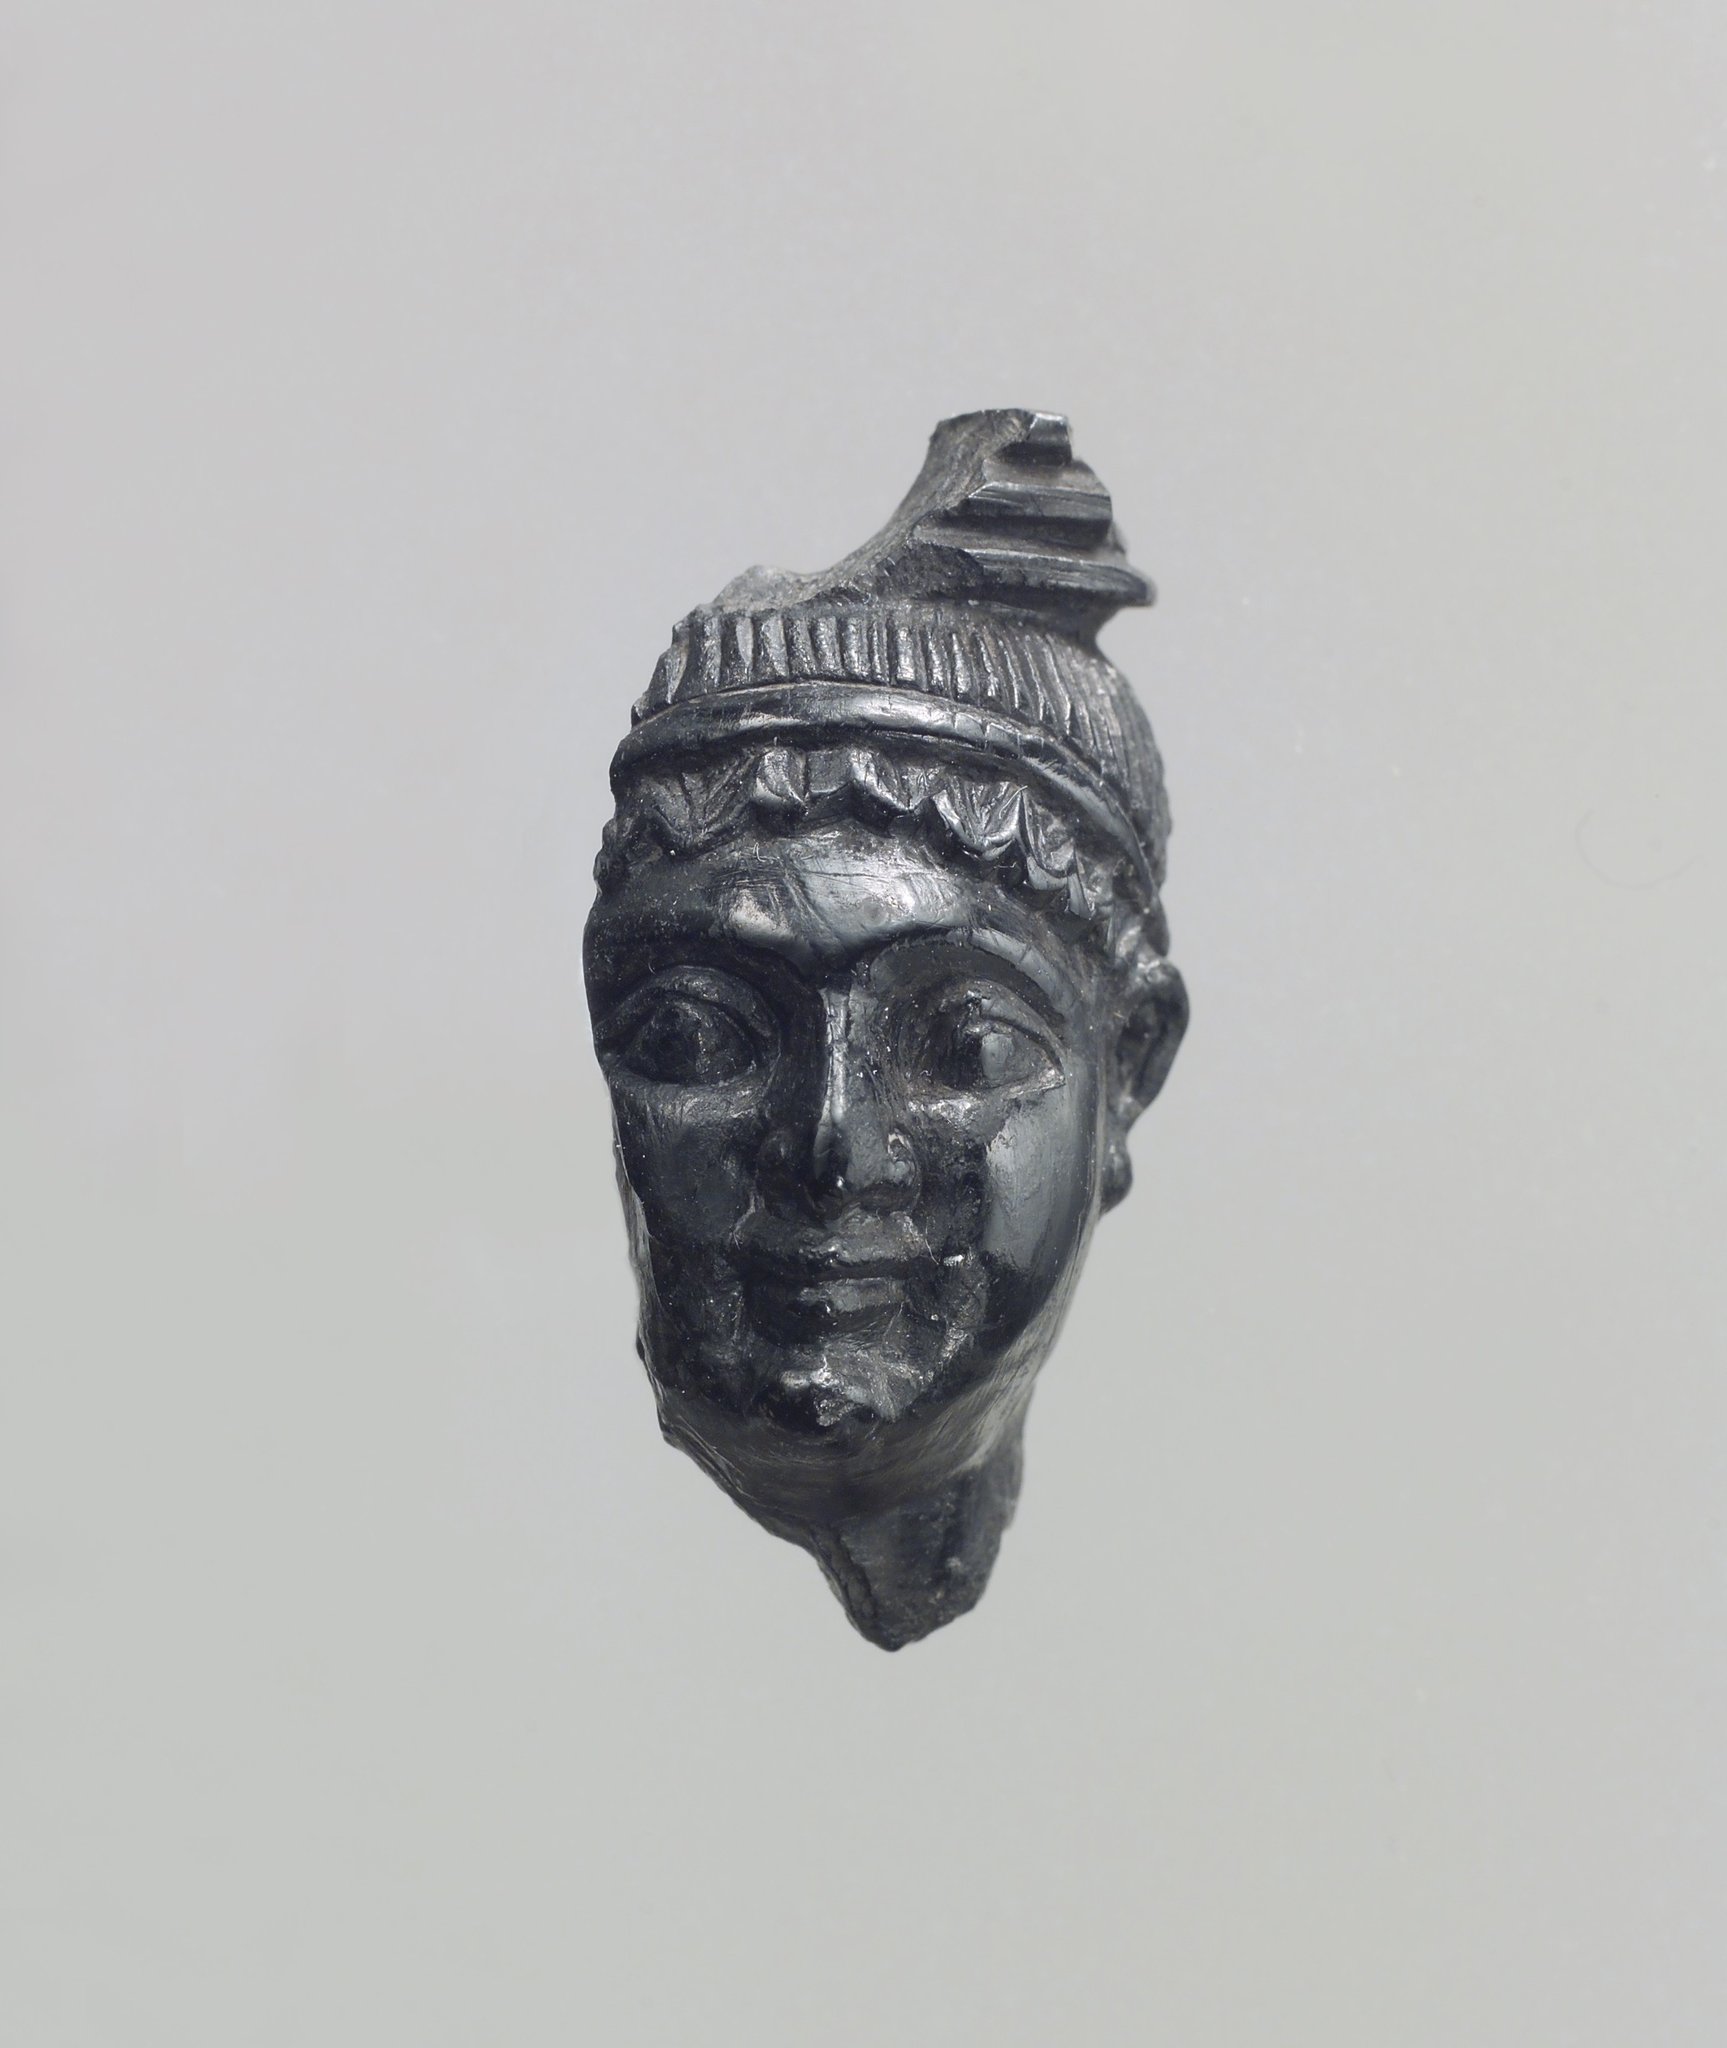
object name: sculpture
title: Head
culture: assyrian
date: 800-601 BCE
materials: ivory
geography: mesopotamia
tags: heads